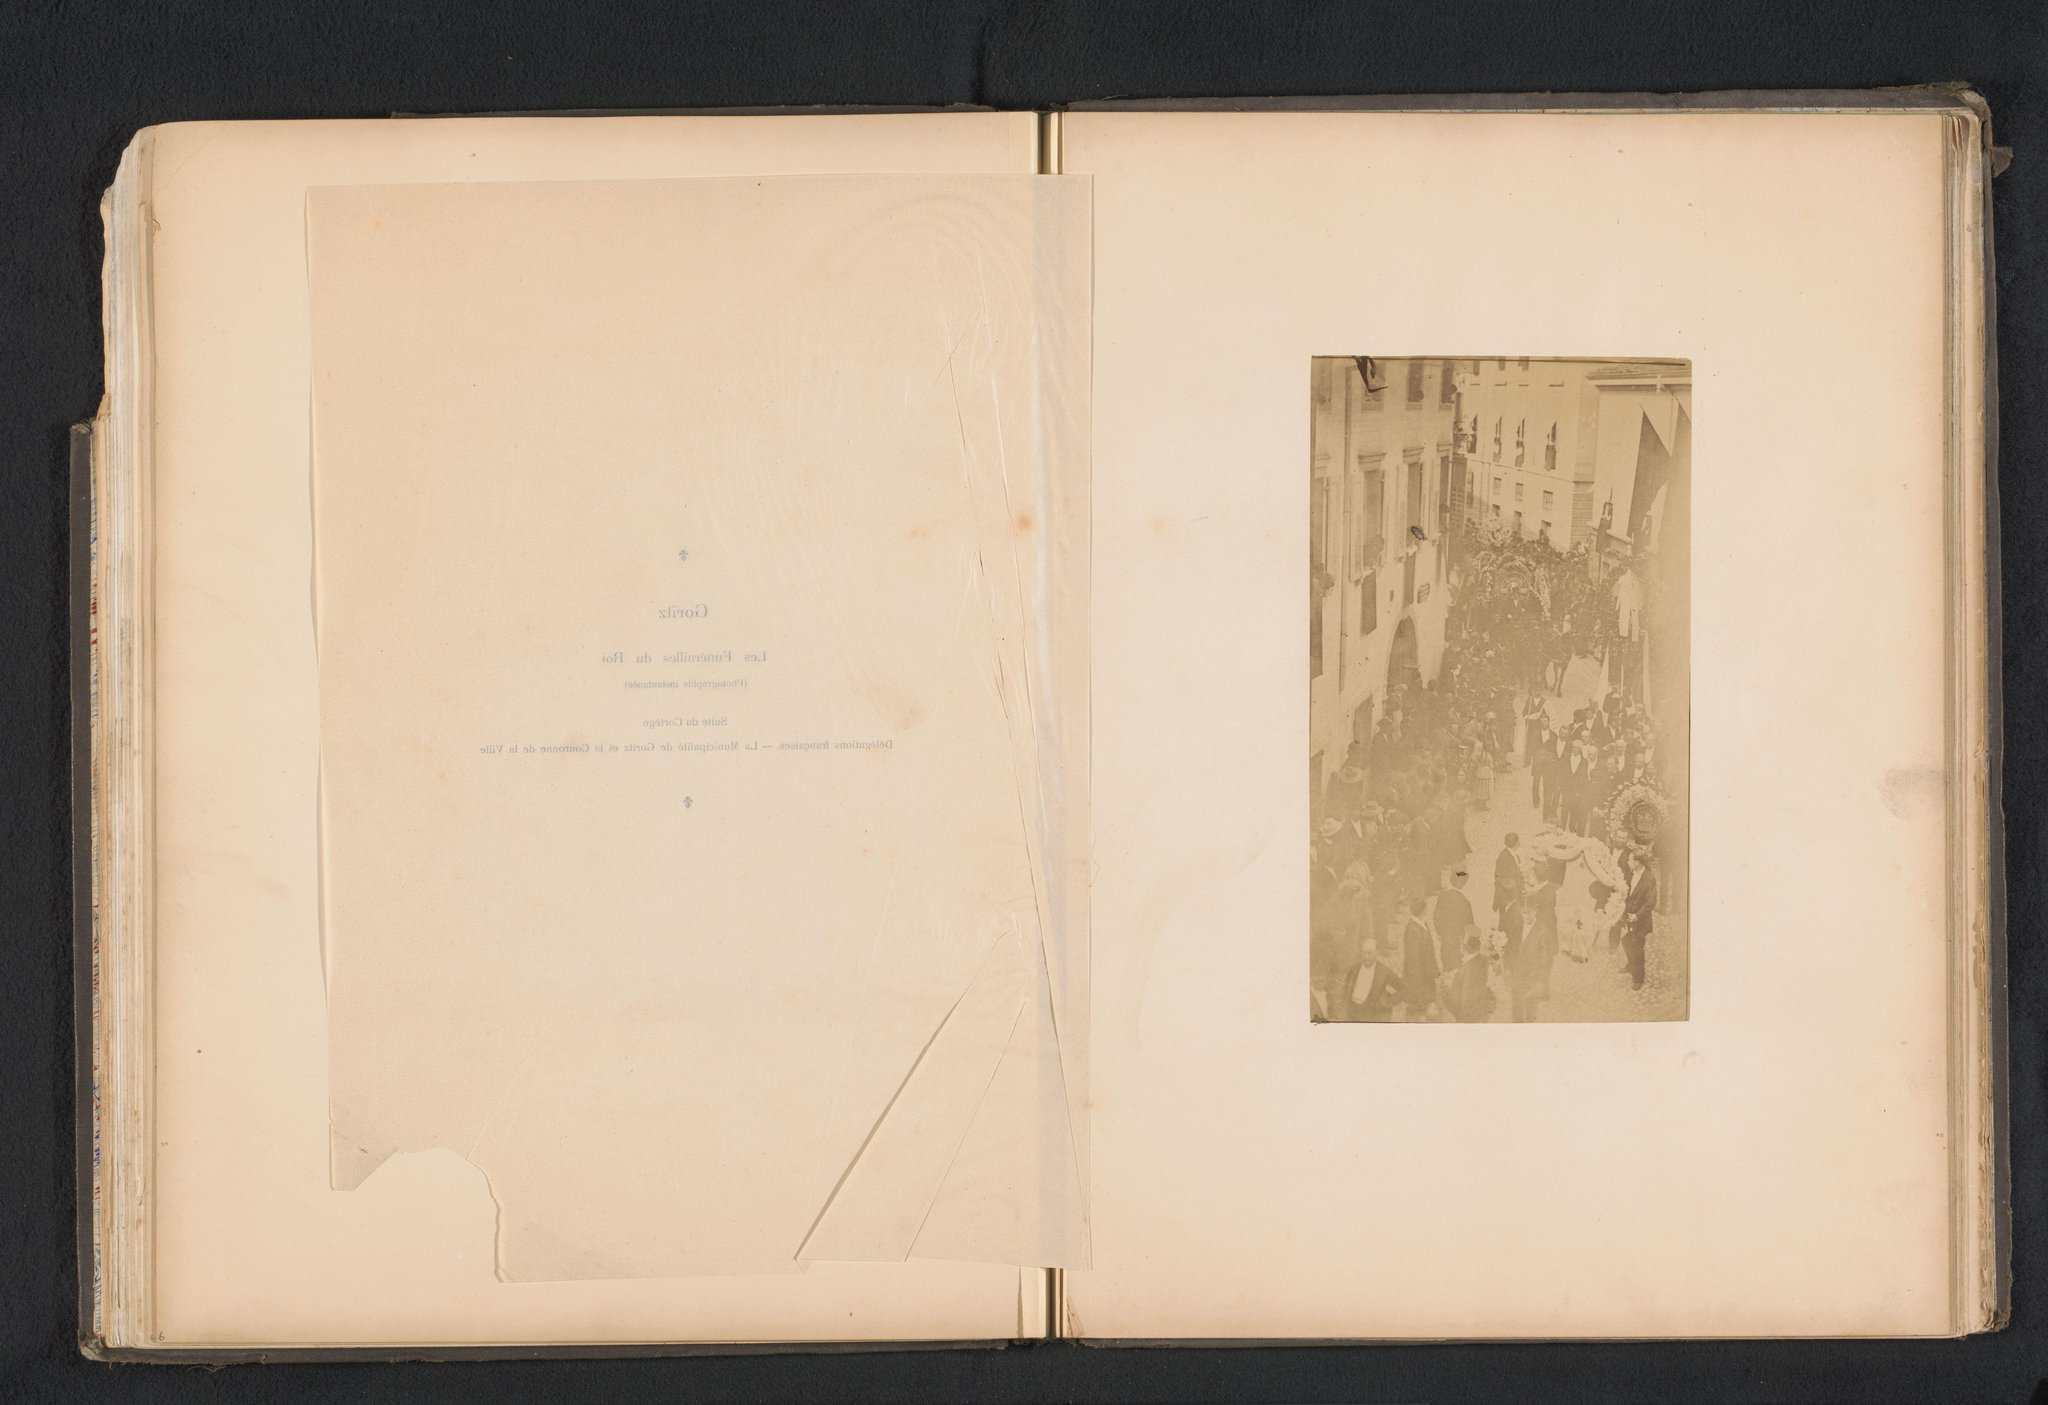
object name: page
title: Begrafenisstoet van Henri d'Artois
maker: a. vallois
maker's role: fotograaf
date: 1878-1883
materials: photographic support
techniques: albumen print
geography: göritz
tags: cortege, funeral procession